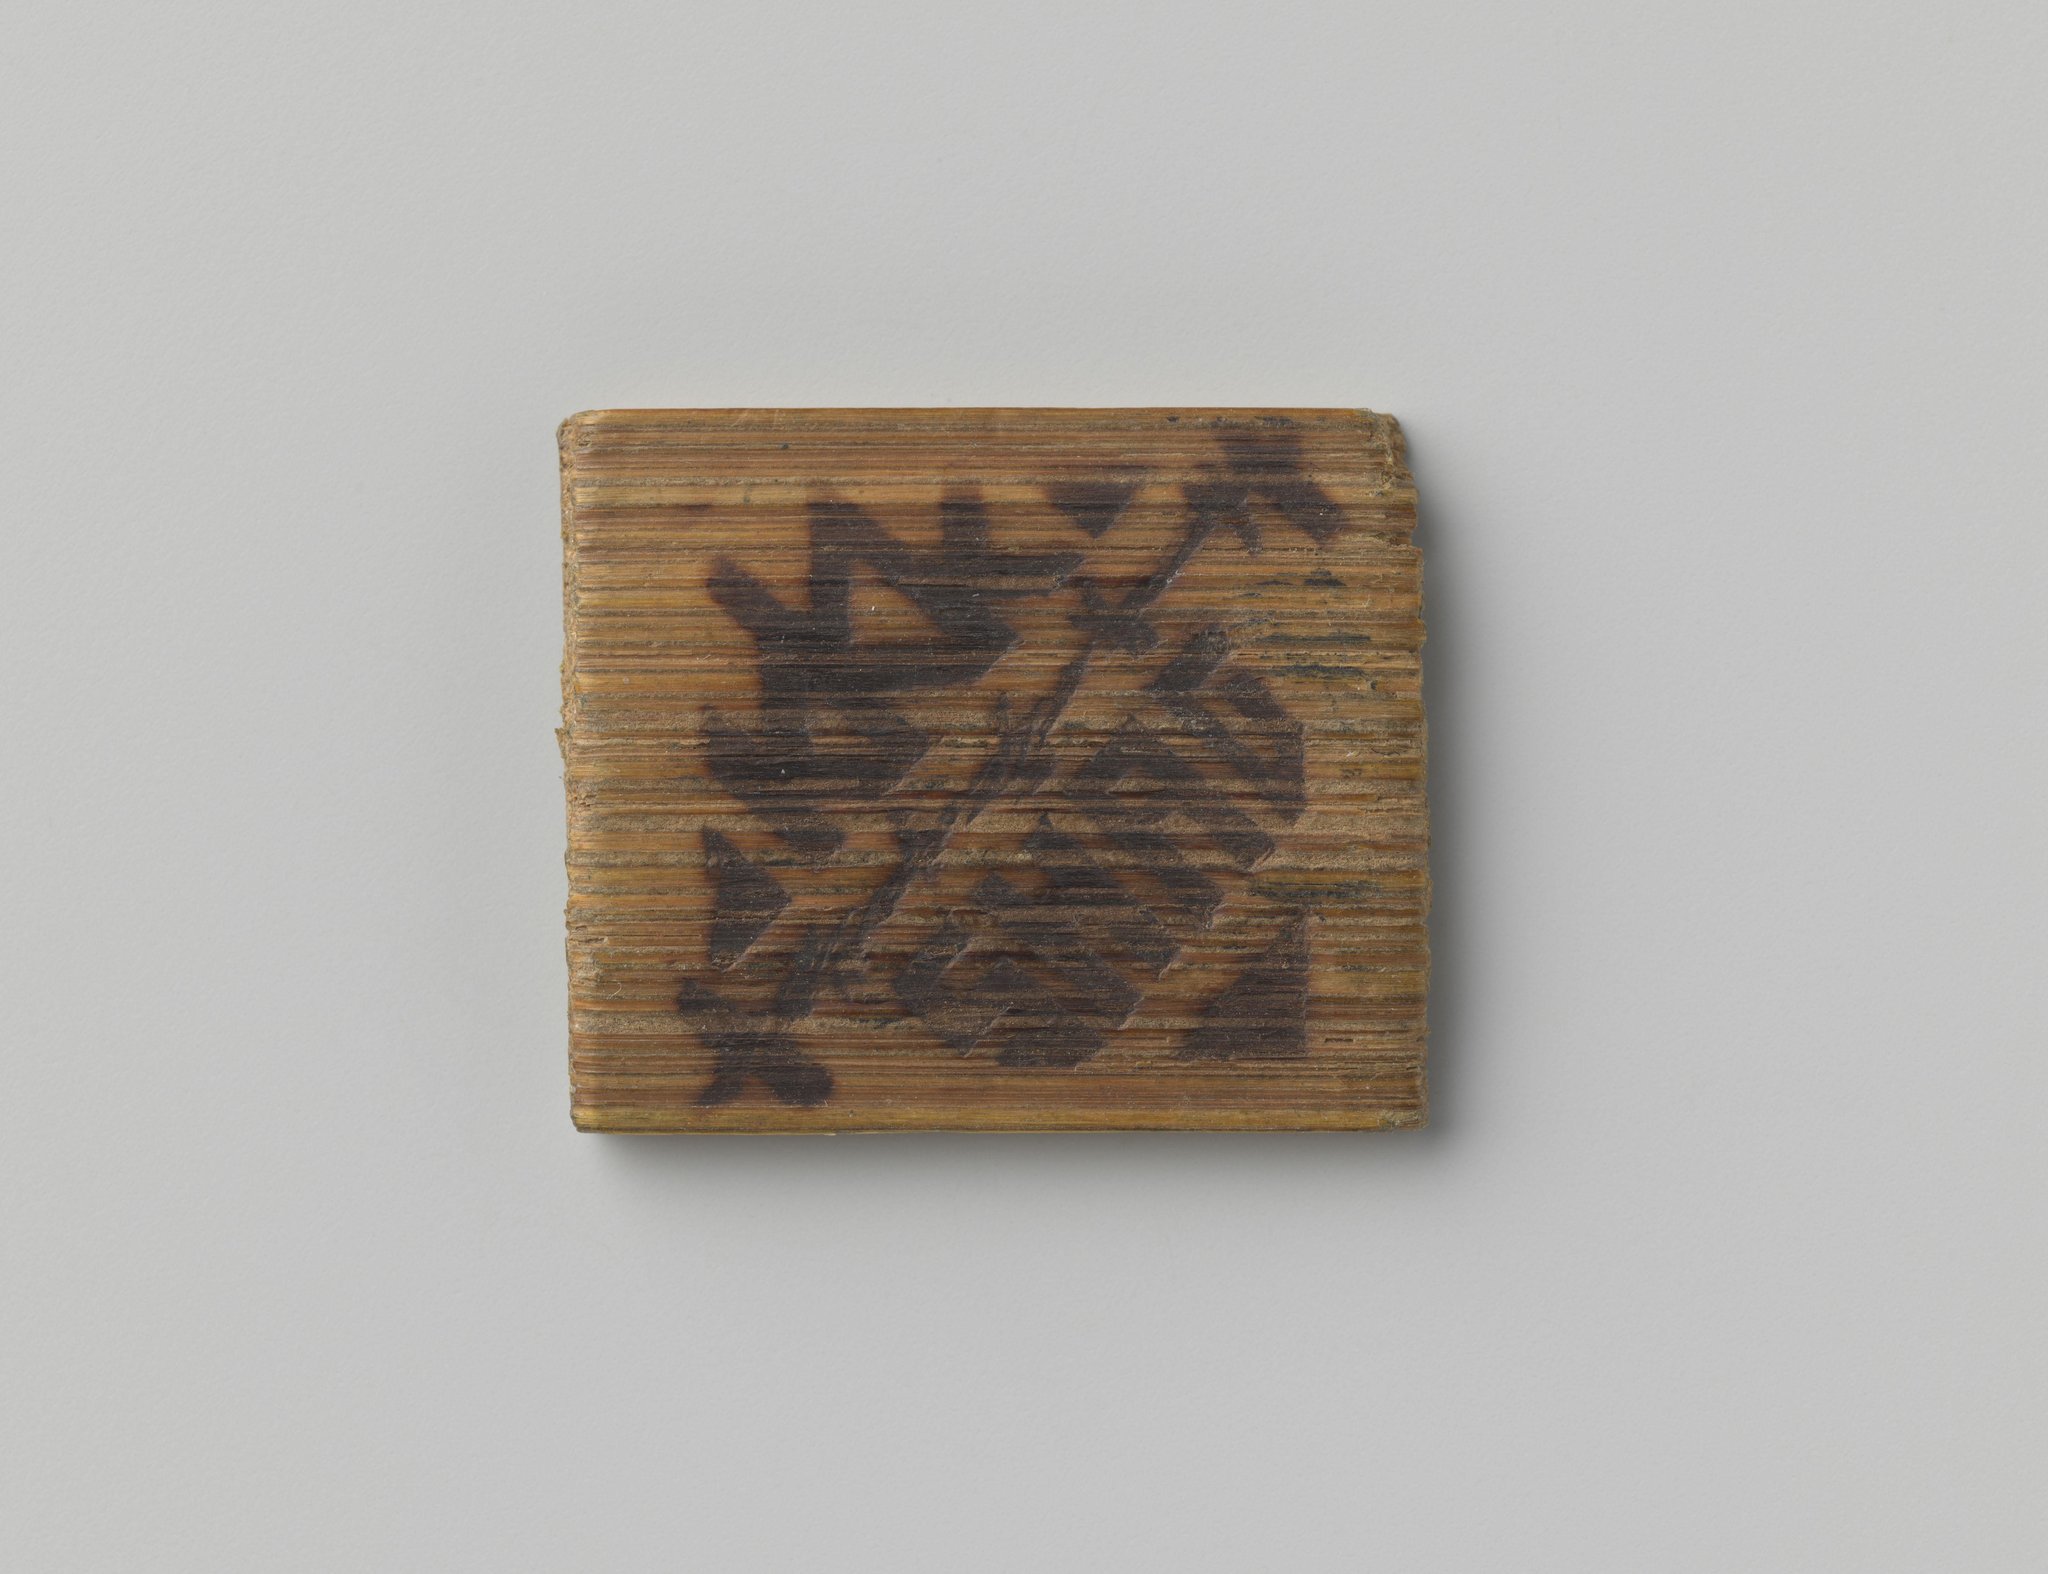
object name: medal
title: Betaalpenning (kamptoken) voor één shag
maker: Anonymous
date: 1943-1945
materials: bamboo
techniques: branding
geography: tjimahi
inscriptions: mark: ‘KKK / SHAG’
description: Plakje bamboe, met daarop het bandmerk met KKK, prikkeldraad en SHAG. Volgens de overlevering gebruikt in het kamp Baros 5 bij Tjimahi (West-Java), waarbij KKK zou staan voor Kale Koppen Kamp.